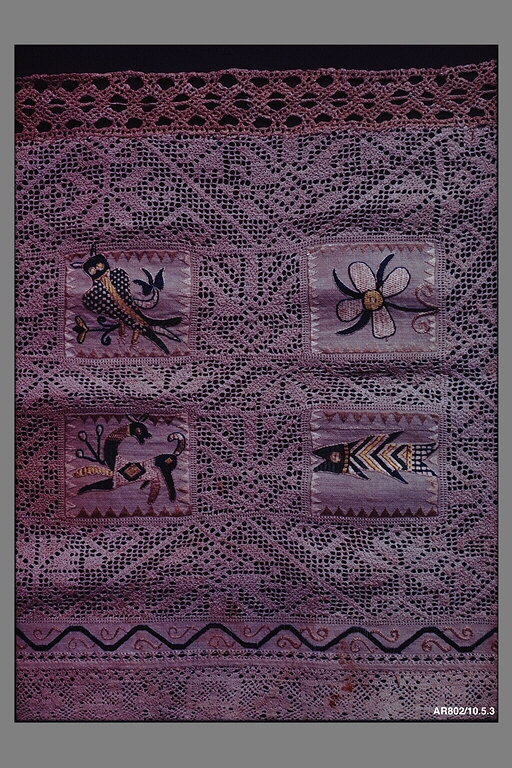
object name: cover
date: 1701-1800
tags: fish,flowers